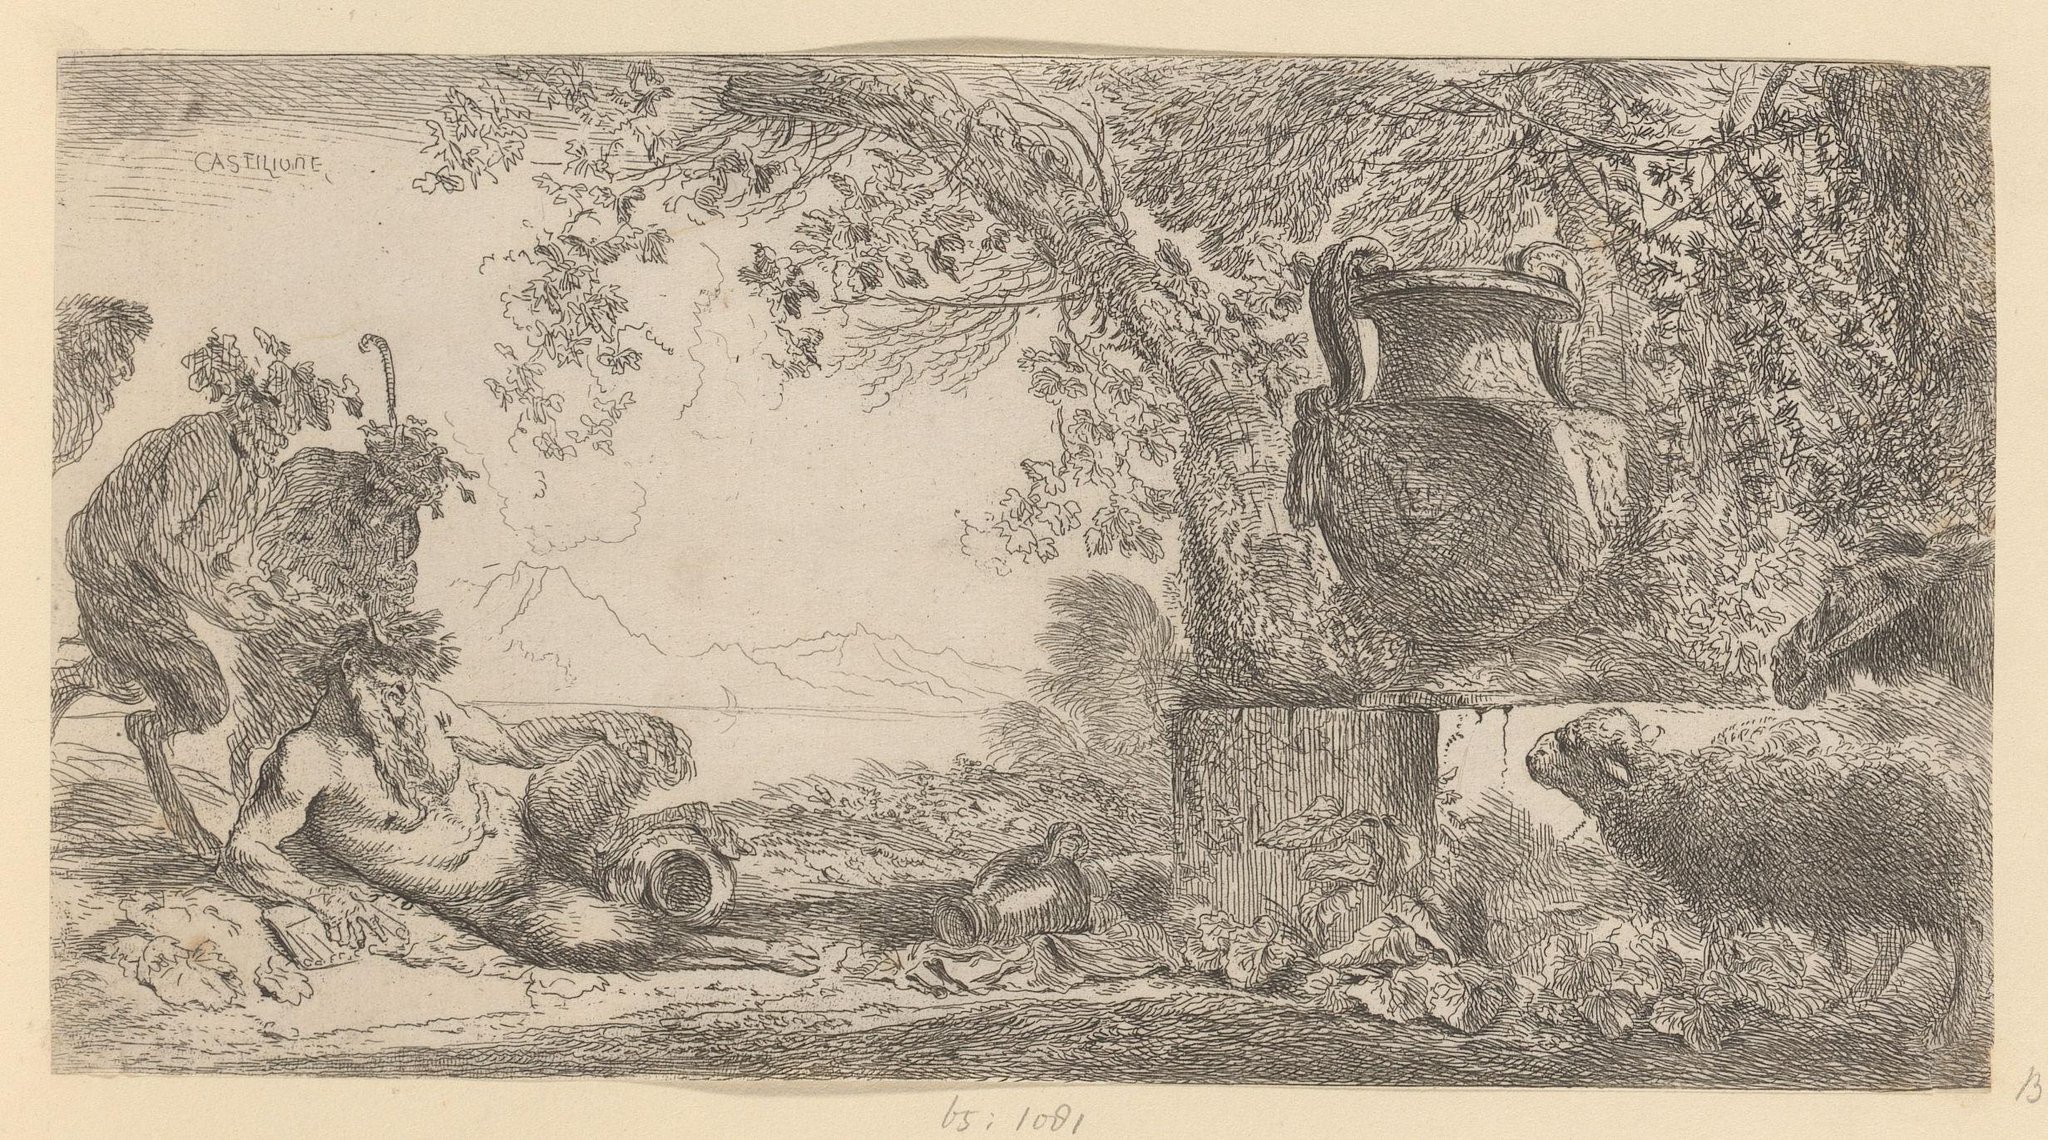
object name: album leaf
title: Landschap met Pan liggend bij een vaas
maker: giovanni benedetto castiglione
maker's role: draughtsman, print maker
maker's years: 1610-1665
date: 1645-1648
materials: paper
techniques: etching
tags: pan-herm, statues, sculptures in garden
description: Prent maakt mogelijk deel uit van een serie van 200 prenten. Deze serie is onder de titel 'A Collection of two hundred original etchings' voor het eerst uitgegeven door J.M. Greery in 1816.